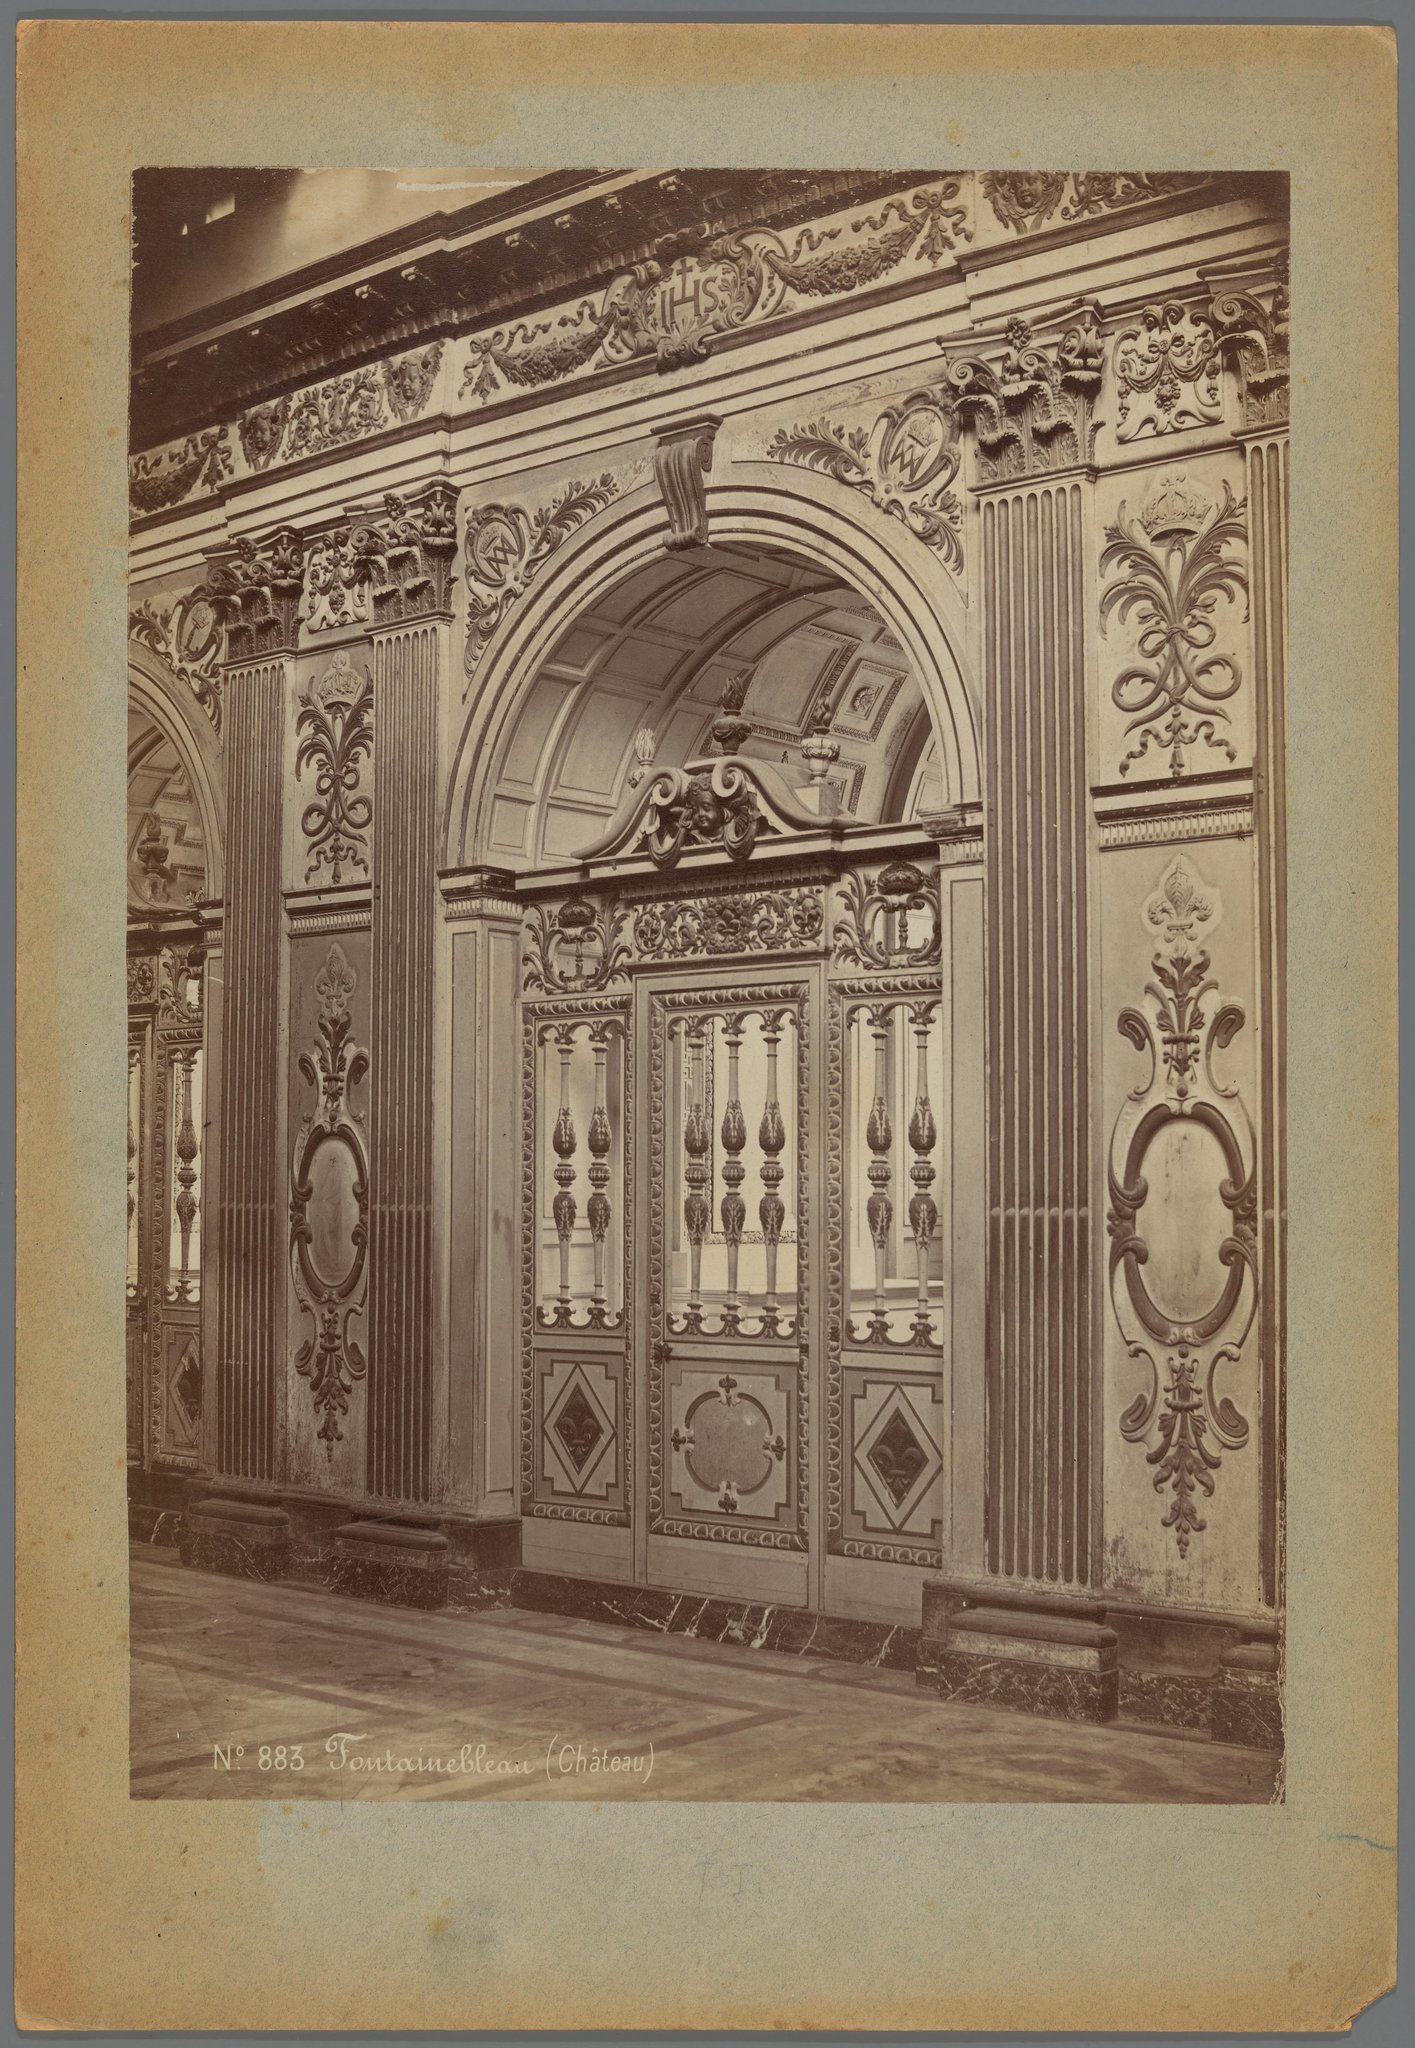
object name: photograph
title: Fontainebleau (Château)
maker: séraphin-médéric mieusement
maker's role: fotograaf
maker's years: 1840-1905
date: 1875-1900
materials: cardboard, photographic support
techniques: albumen print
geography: fontainebleau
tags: palace, interior ~ representation of a building, closed door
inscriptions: inscription: ‘MONUMENTS HISTORIQUES’, number: ‘No. 883’, name: ‘KUNSTBOEKHANDEL J. A. G. DE LEUR PHOTOGRAAF - UITGEVER HUIGENSPARK, 40b. DEN HAAG.’, name: ‘MIEUSEMENT PHOTOGRAPHE’, collector's mark: Lugt 3937